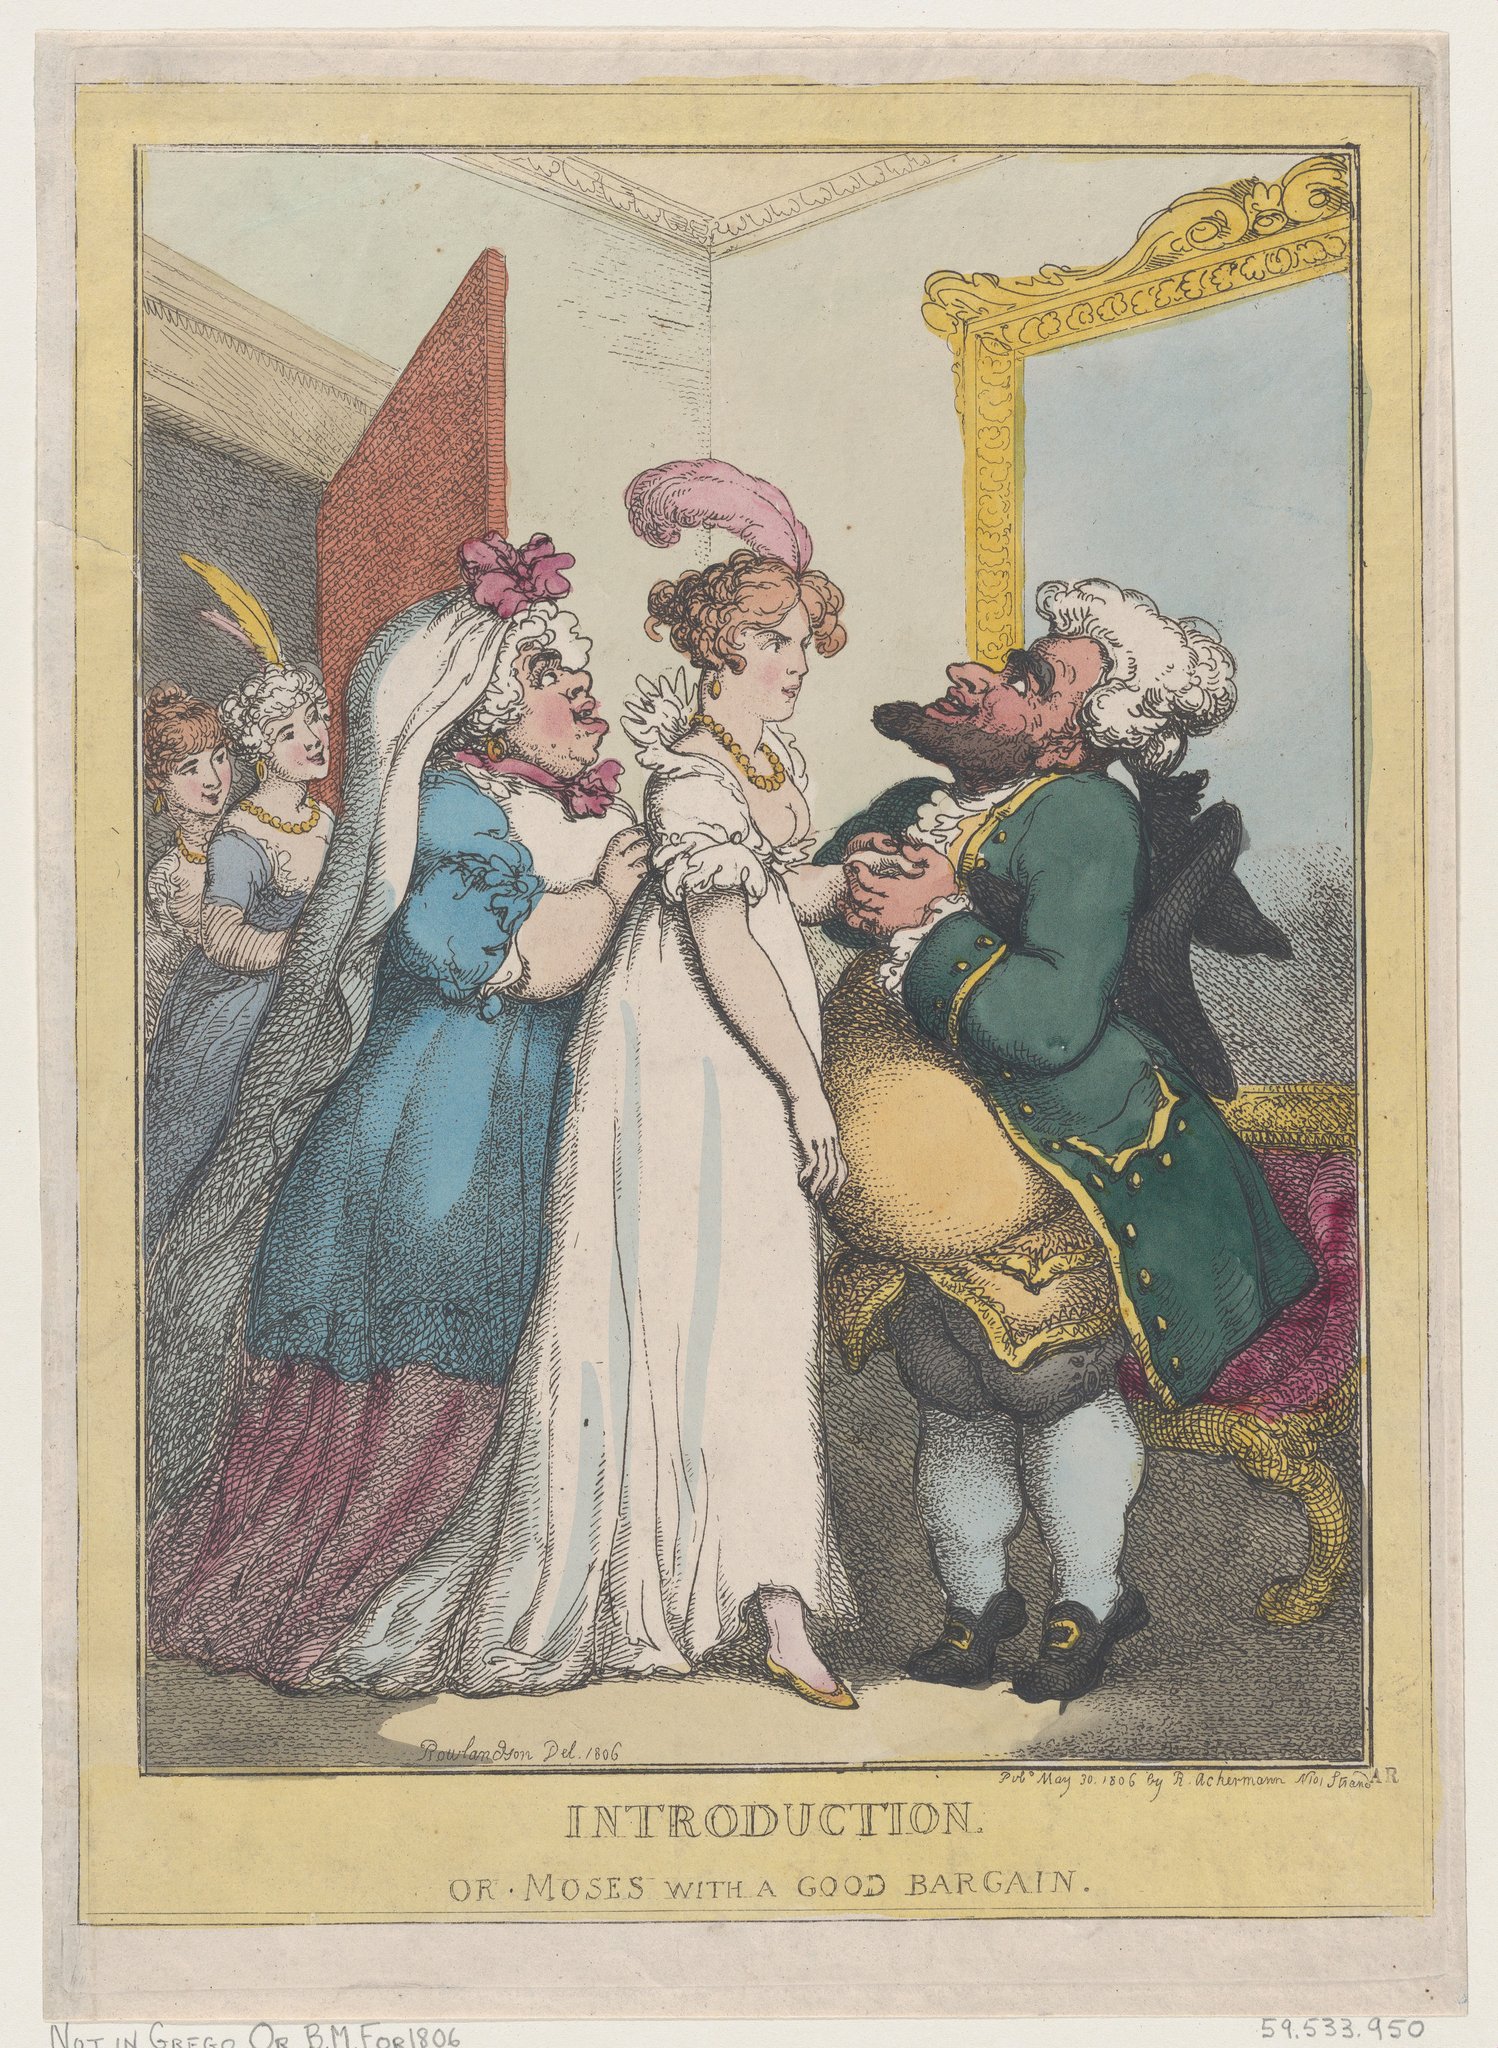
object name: print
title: Introduction, or Moses with a Good Bargain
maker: thomas rowlandson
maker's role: artist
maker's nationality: british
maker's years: 1757-1827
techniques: etching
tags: satire,men,women